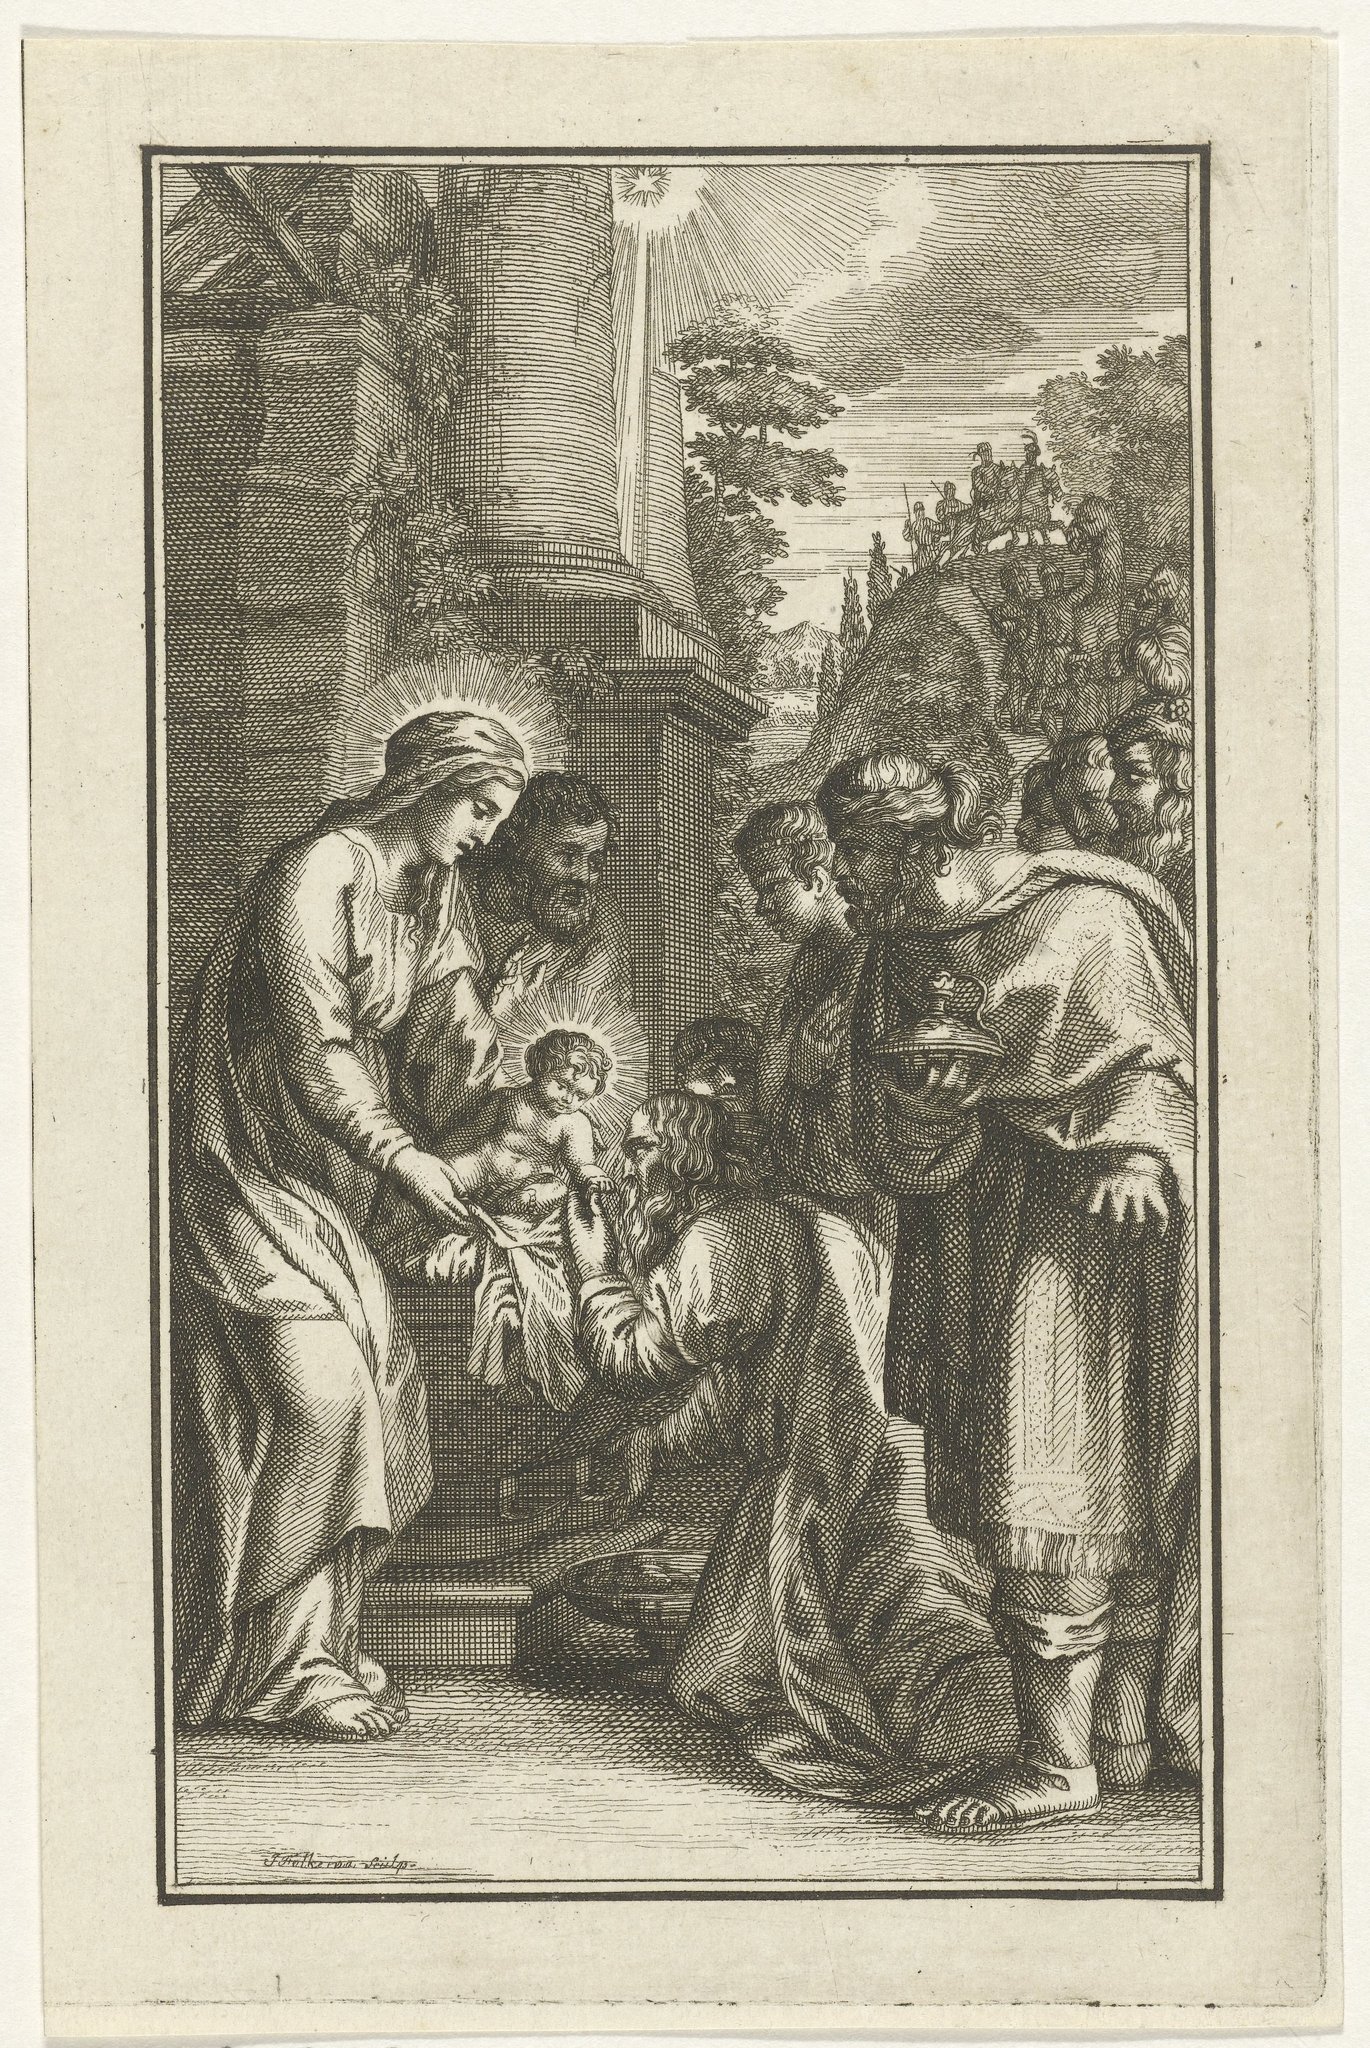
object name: print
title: Aanbidding der koningen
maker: jacob folkema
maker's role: draughtsman, print maker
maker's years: 1692-1767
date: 1702-1767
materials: paper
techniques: etching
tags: adoration of the kings: the wise men present their gifts to the christ-child (gold, frankincense and myrrh)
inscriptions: collector's mark: Lugt 240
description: Het Christuskind wordt, in het bijzijn van Maria en Jozef, aanbeden door de drie Wijzen uit het Oosten die zich met hun geschenken voor het Kind hebben opgesteld.